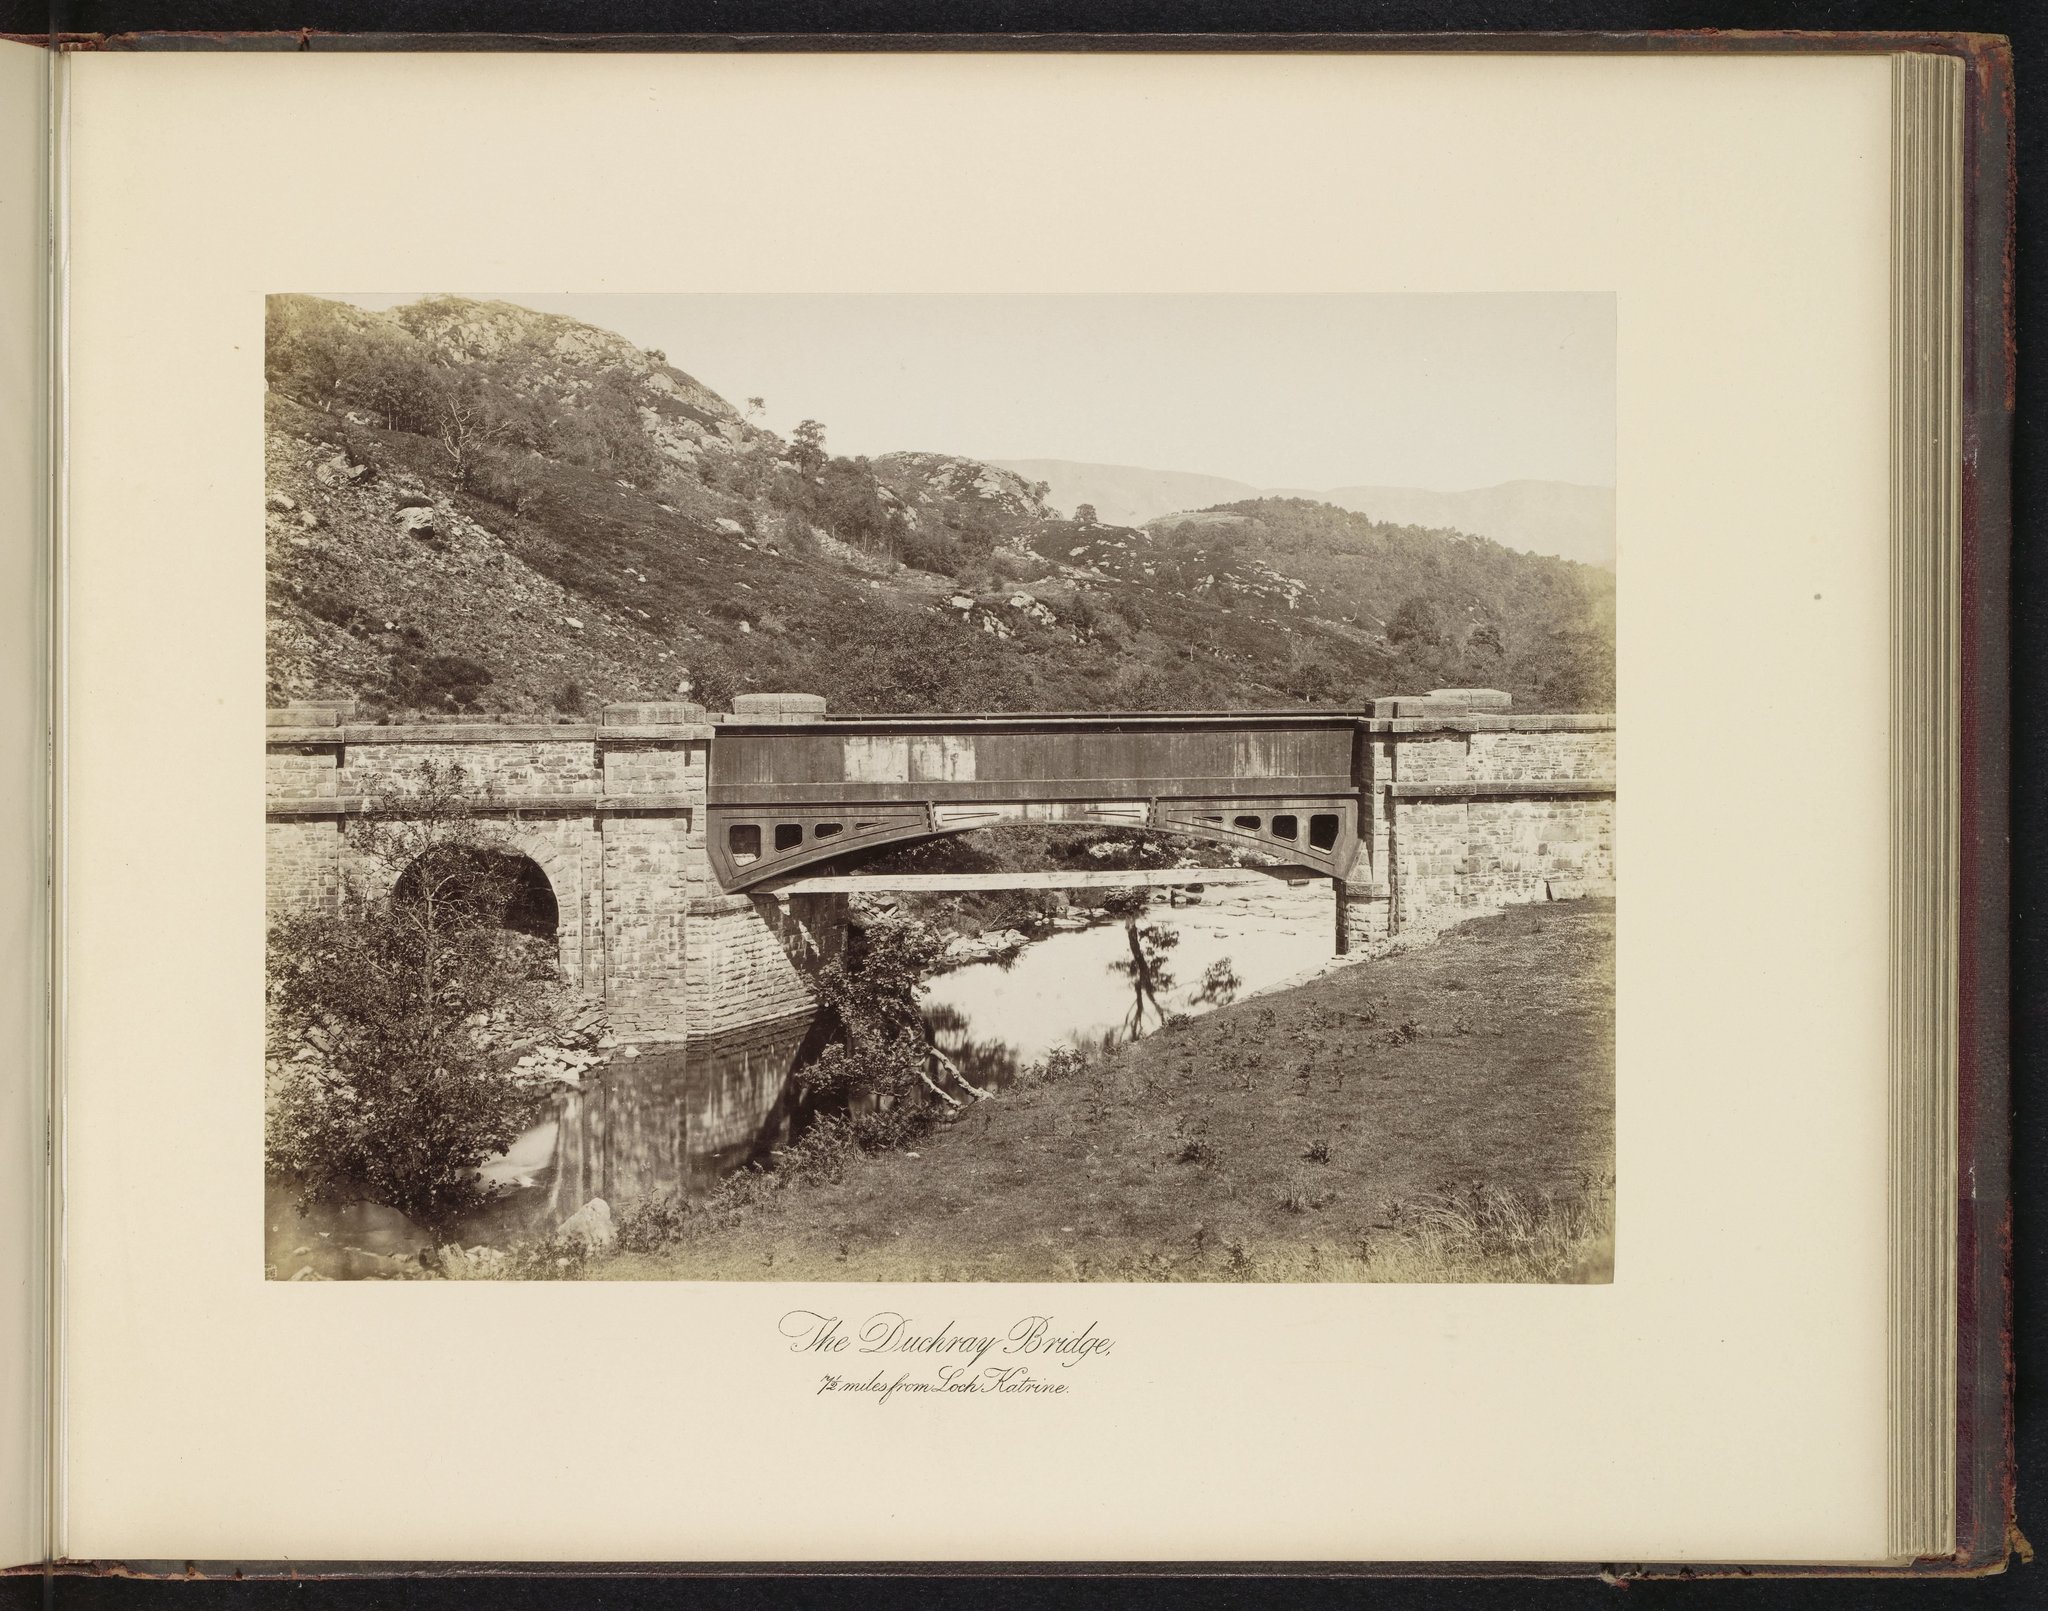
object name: photograph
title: The Duchray Bridge, 7 1/2 miles from Loch Katrine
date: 1879-1889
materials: photographic support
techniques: albumen print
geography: stirling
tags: landscape with bridge, viaduct or aqueduct